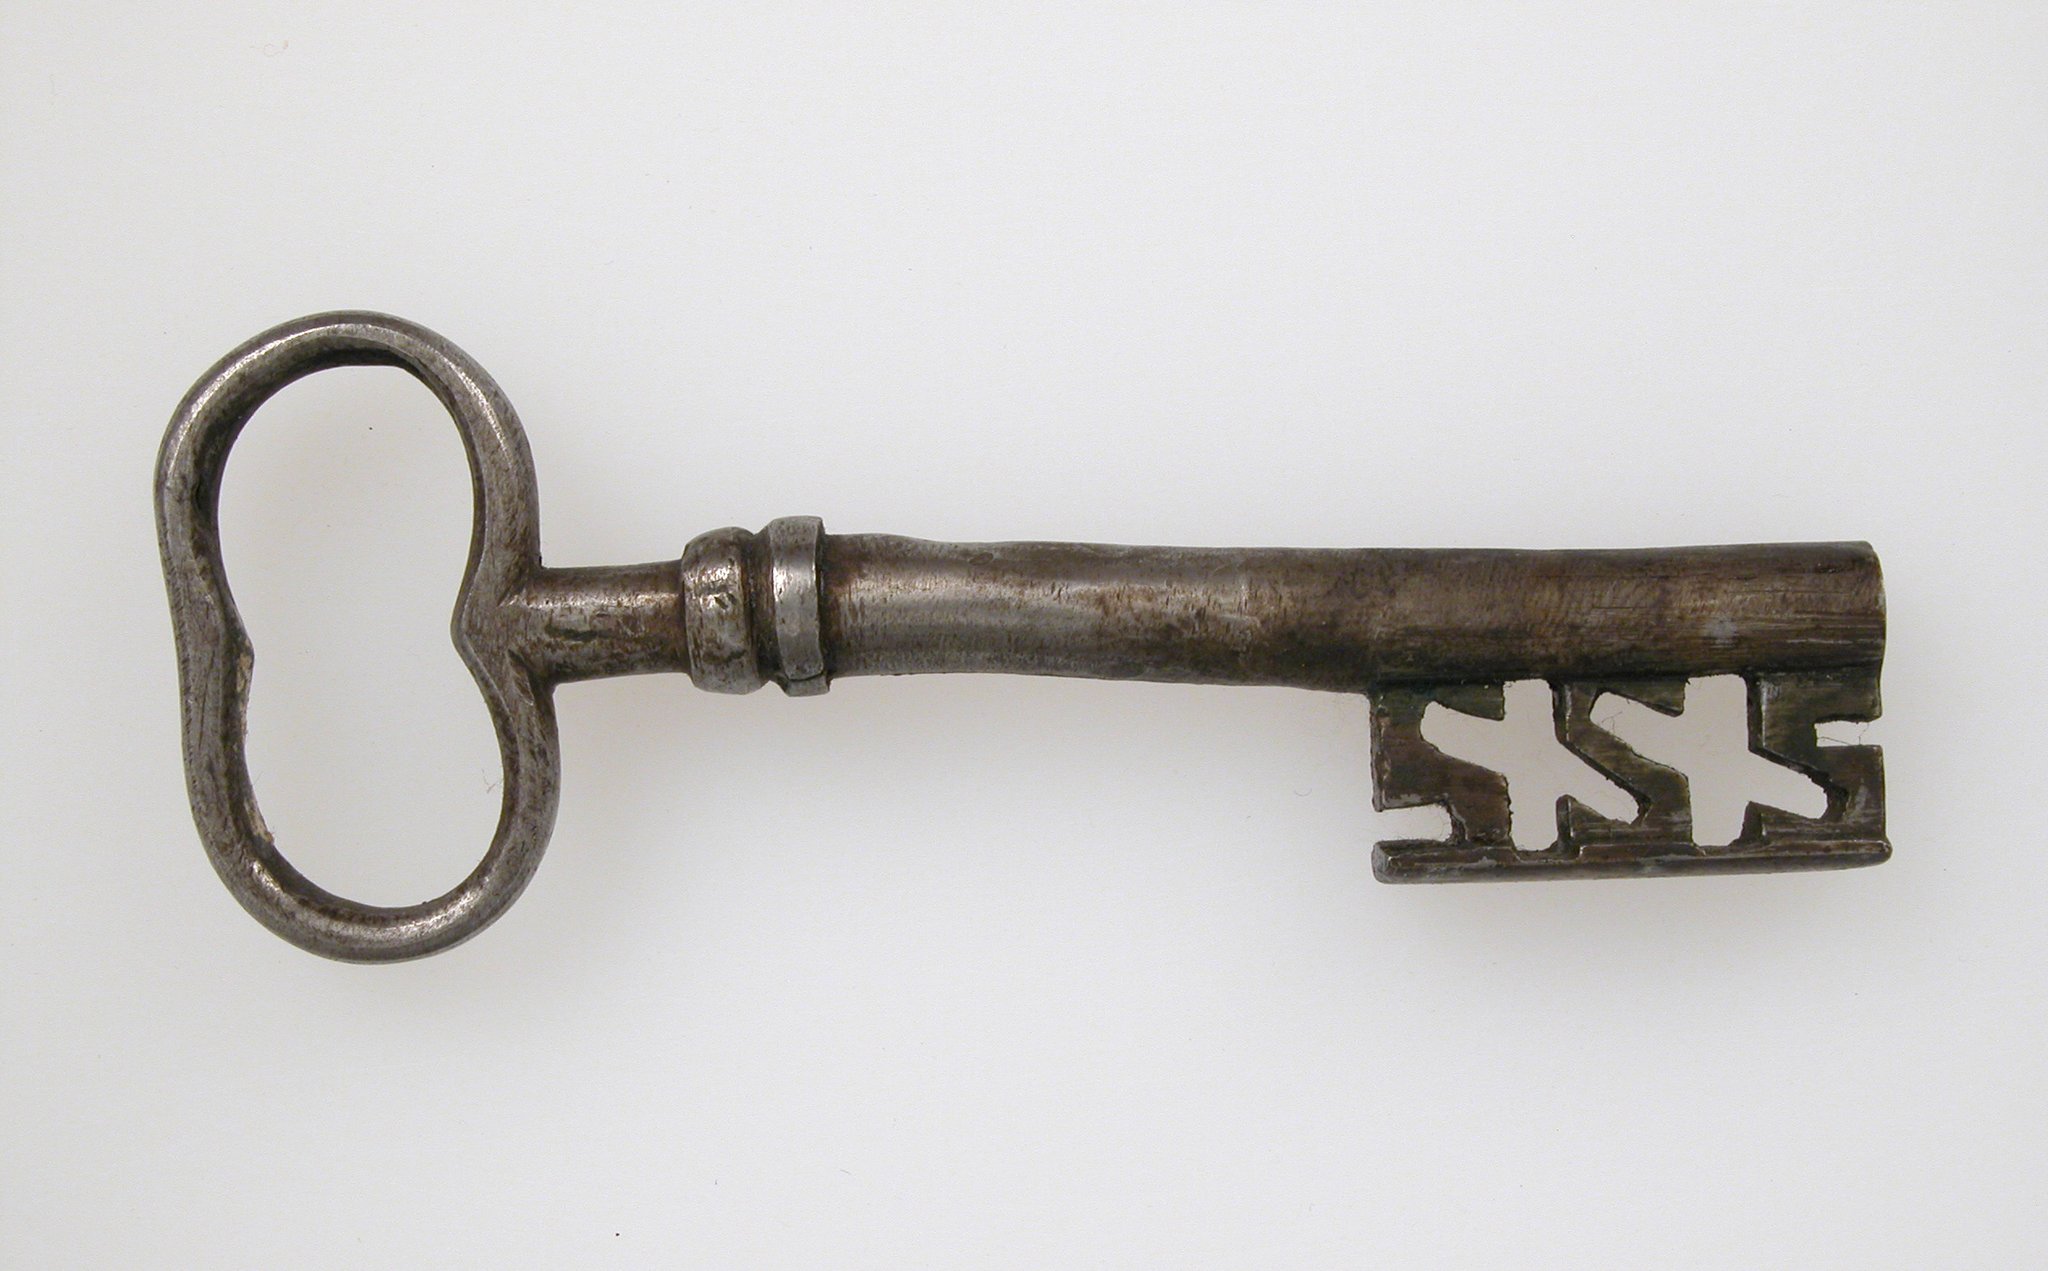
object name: key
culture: german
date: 1401-1500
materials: iron